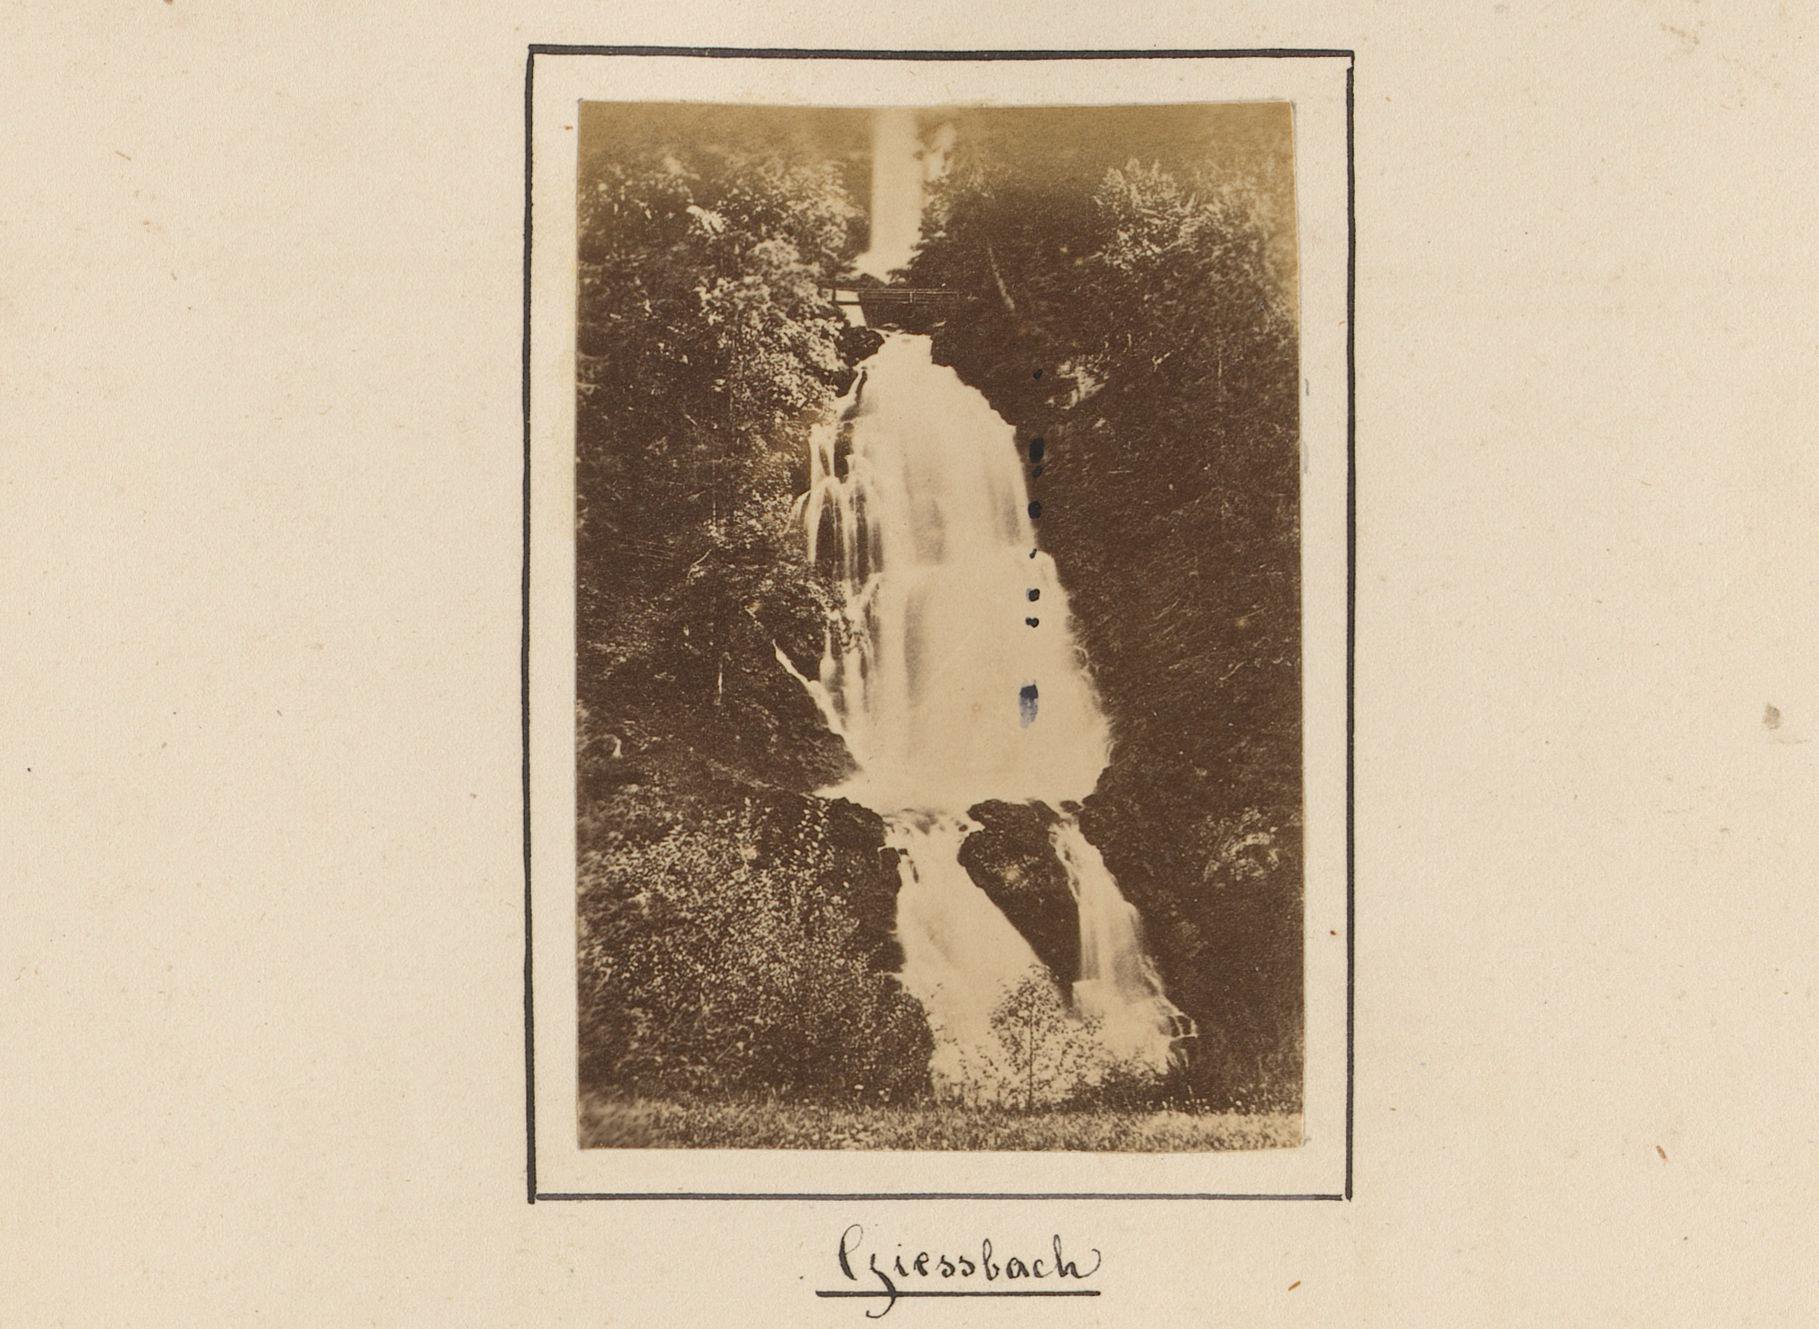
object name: photograph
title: Giessbach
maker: Anonymous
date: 1870-1890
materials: paper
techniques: albumen print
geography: giessbachwaterval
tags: waterfall